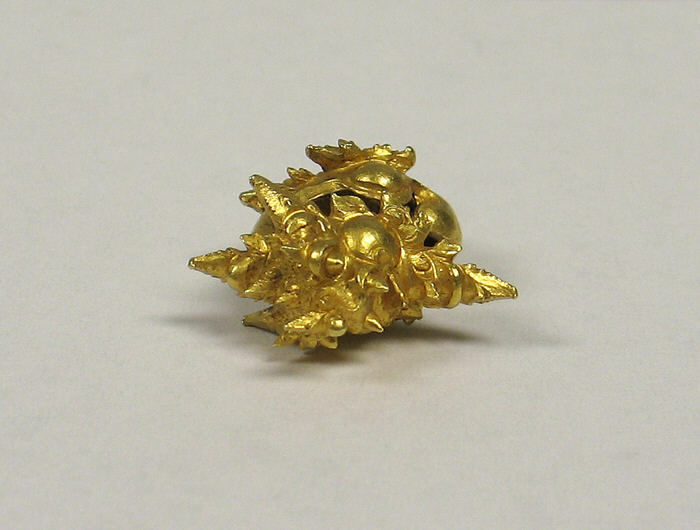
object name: ear ornament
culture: indonesian, central java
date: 701-1200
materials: gold